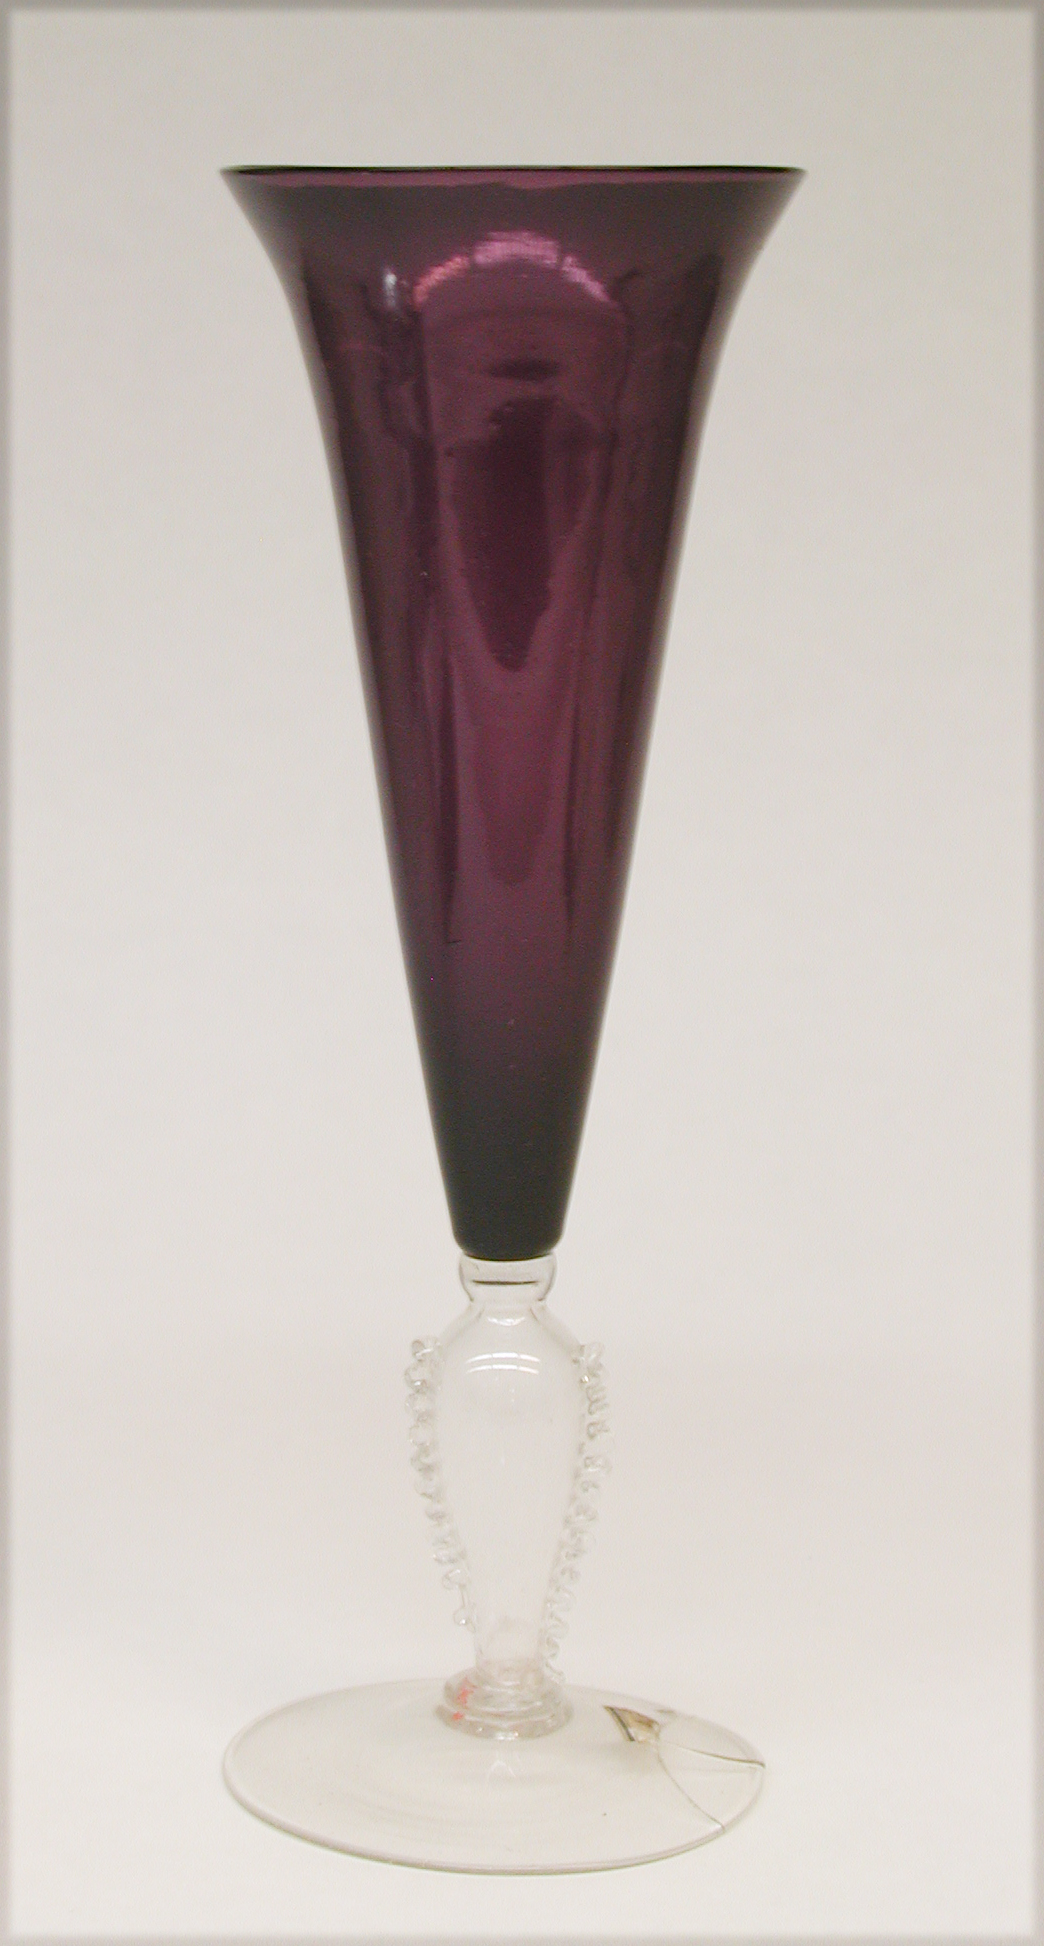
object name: wineglass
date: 1501-1600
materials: glass